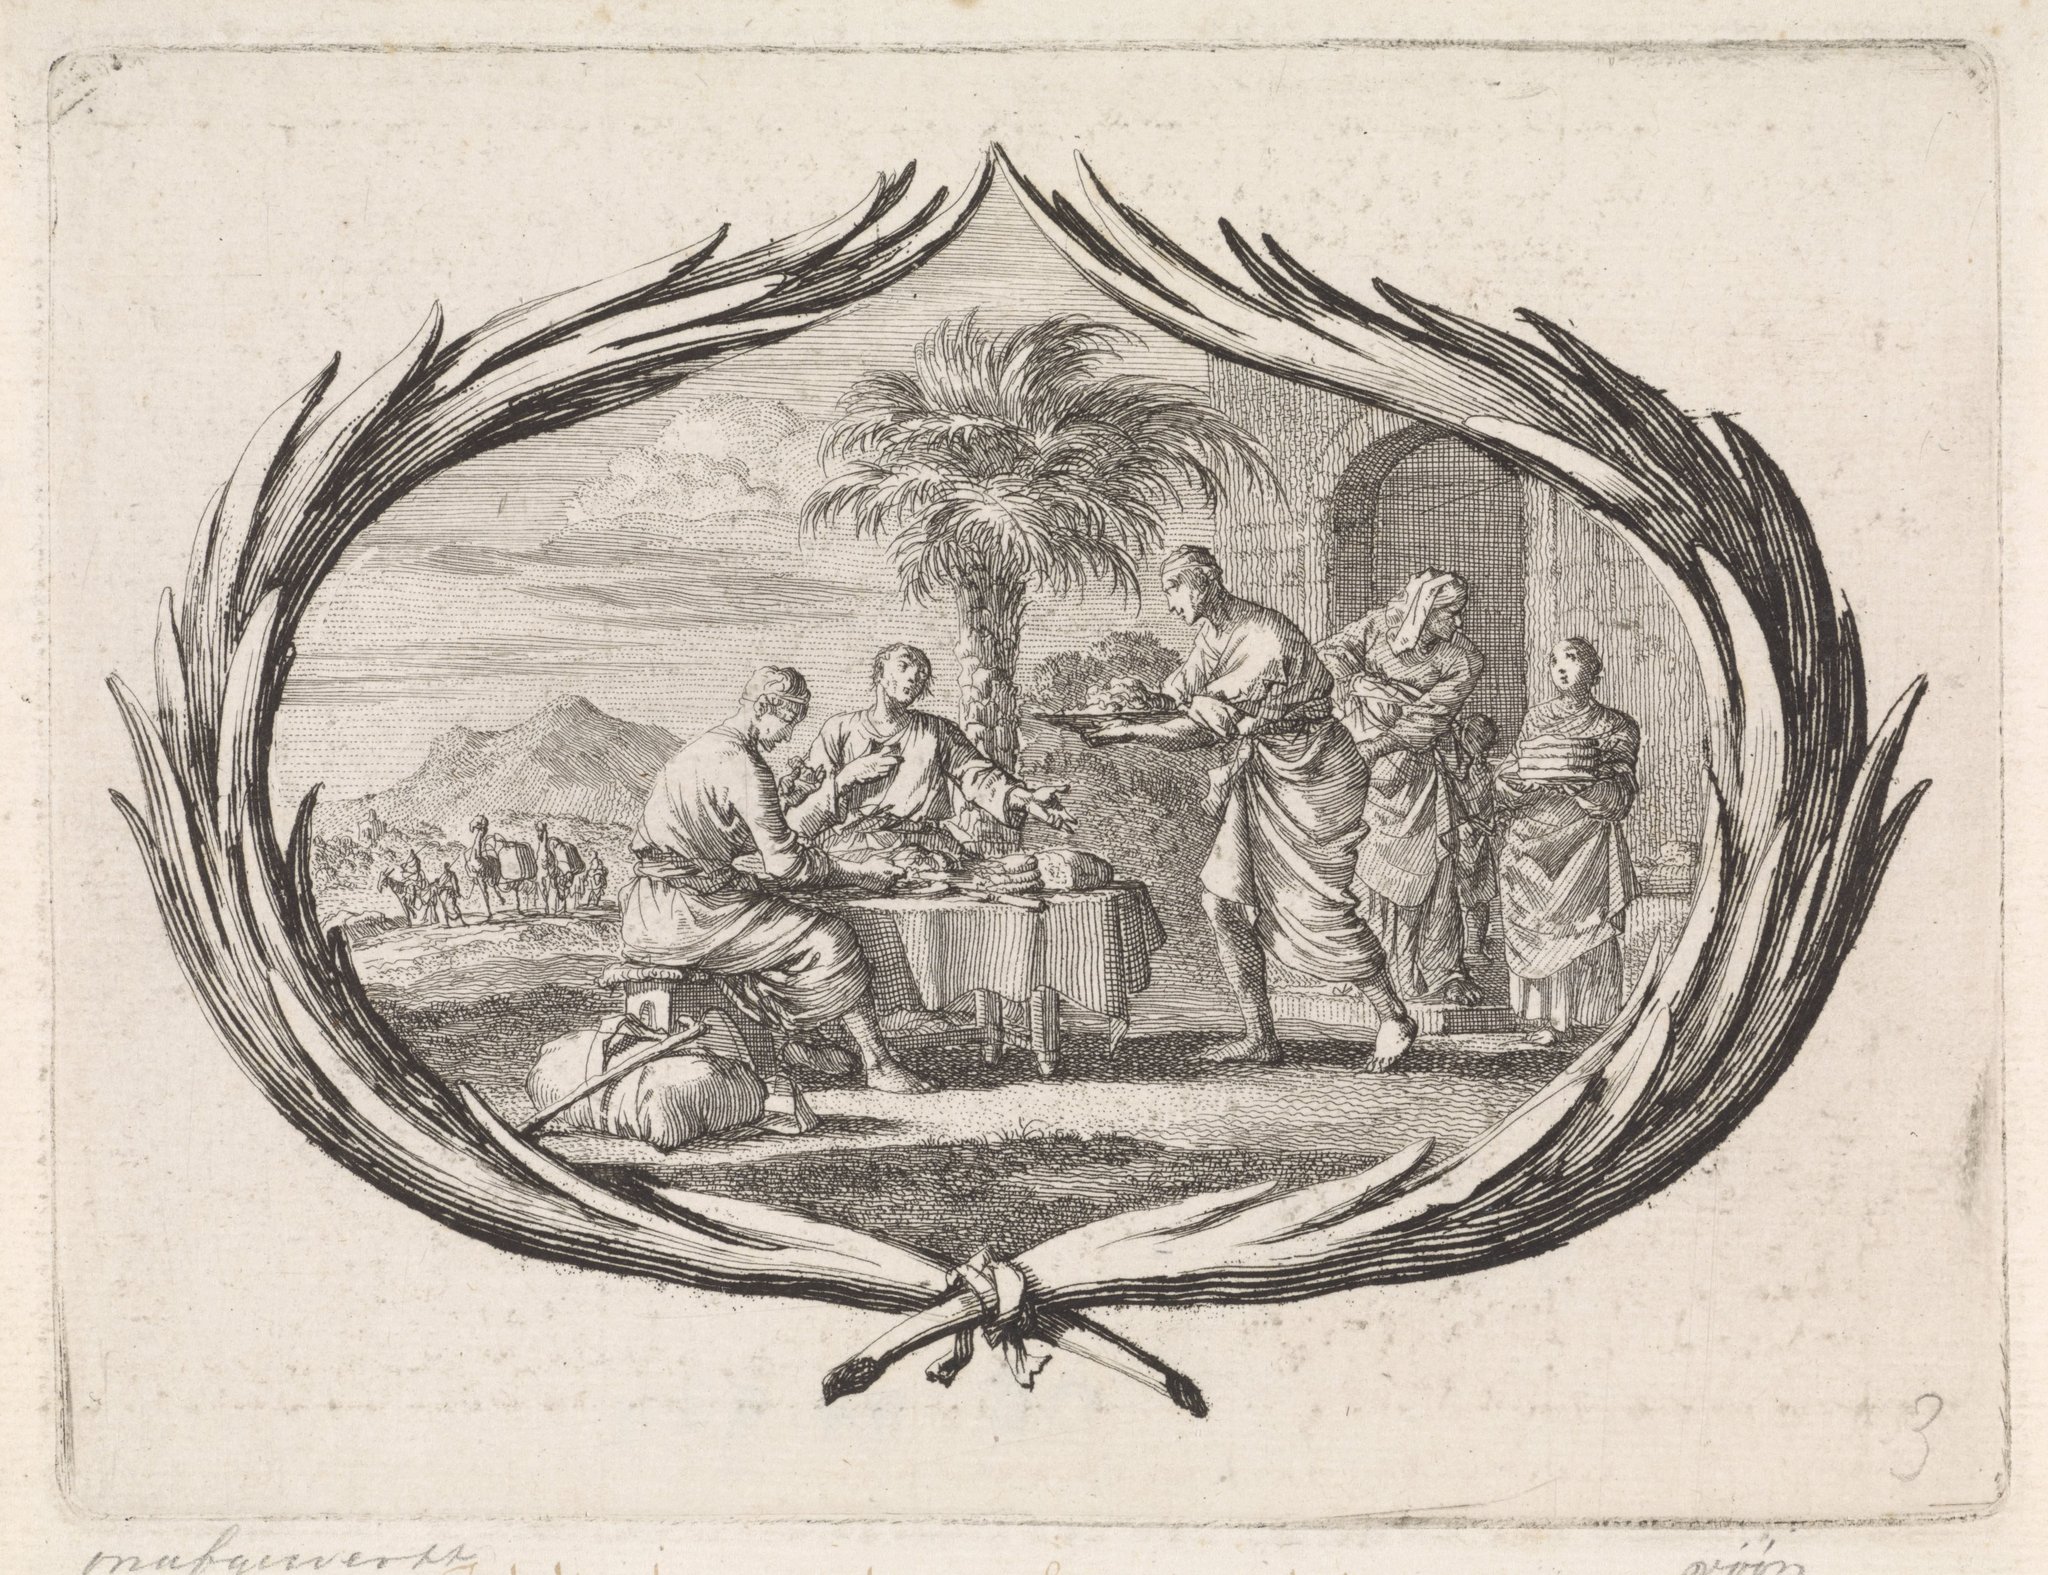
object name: print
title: Hongerigen spijzen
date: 1700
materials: paper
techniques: etching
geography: amsterdam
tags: ornament ~ cartouche, feeding the hungry, 'esuriens cibatur' ~ one of the (seven) acts of mercy, (family) meal - cc - out of doors, 'en route', traveller under way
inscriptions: collector's mark: Lugt 2228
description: Proefdruk van een boekillustratie voor David Martin. Historie des Ouden en Nieuwen Testaments, verrykt met meer dan vierhonderd printverbeeldingen. Deel II. Amsterdam: Pieter Mortier, 1700.